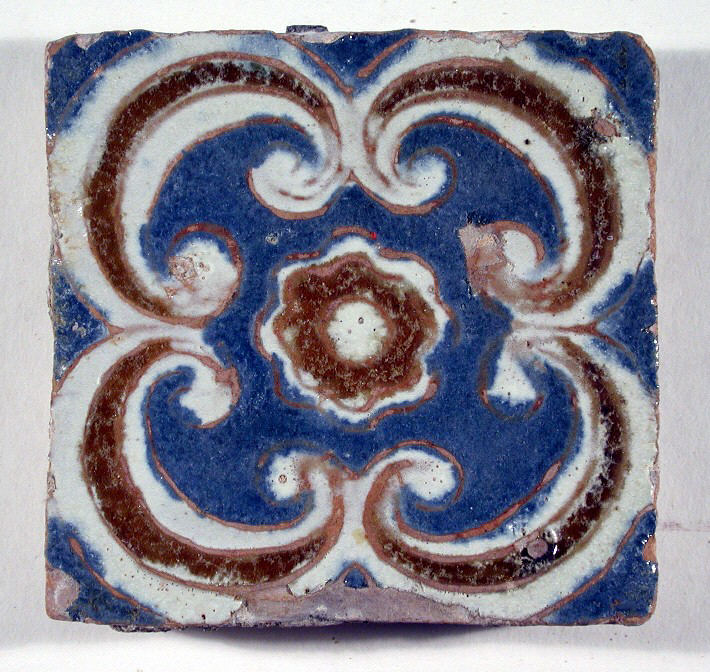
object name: pavement tile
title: Pavement tiles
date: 1501-1700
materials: earthenware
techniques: glazing